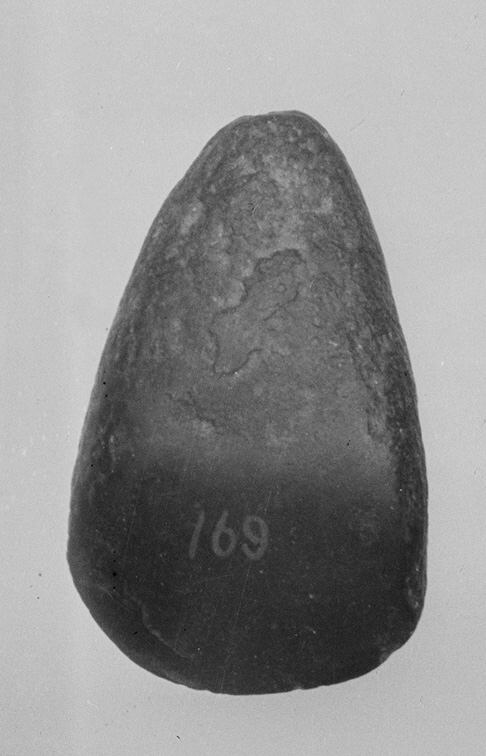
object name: hatchet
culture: swiss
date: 1902